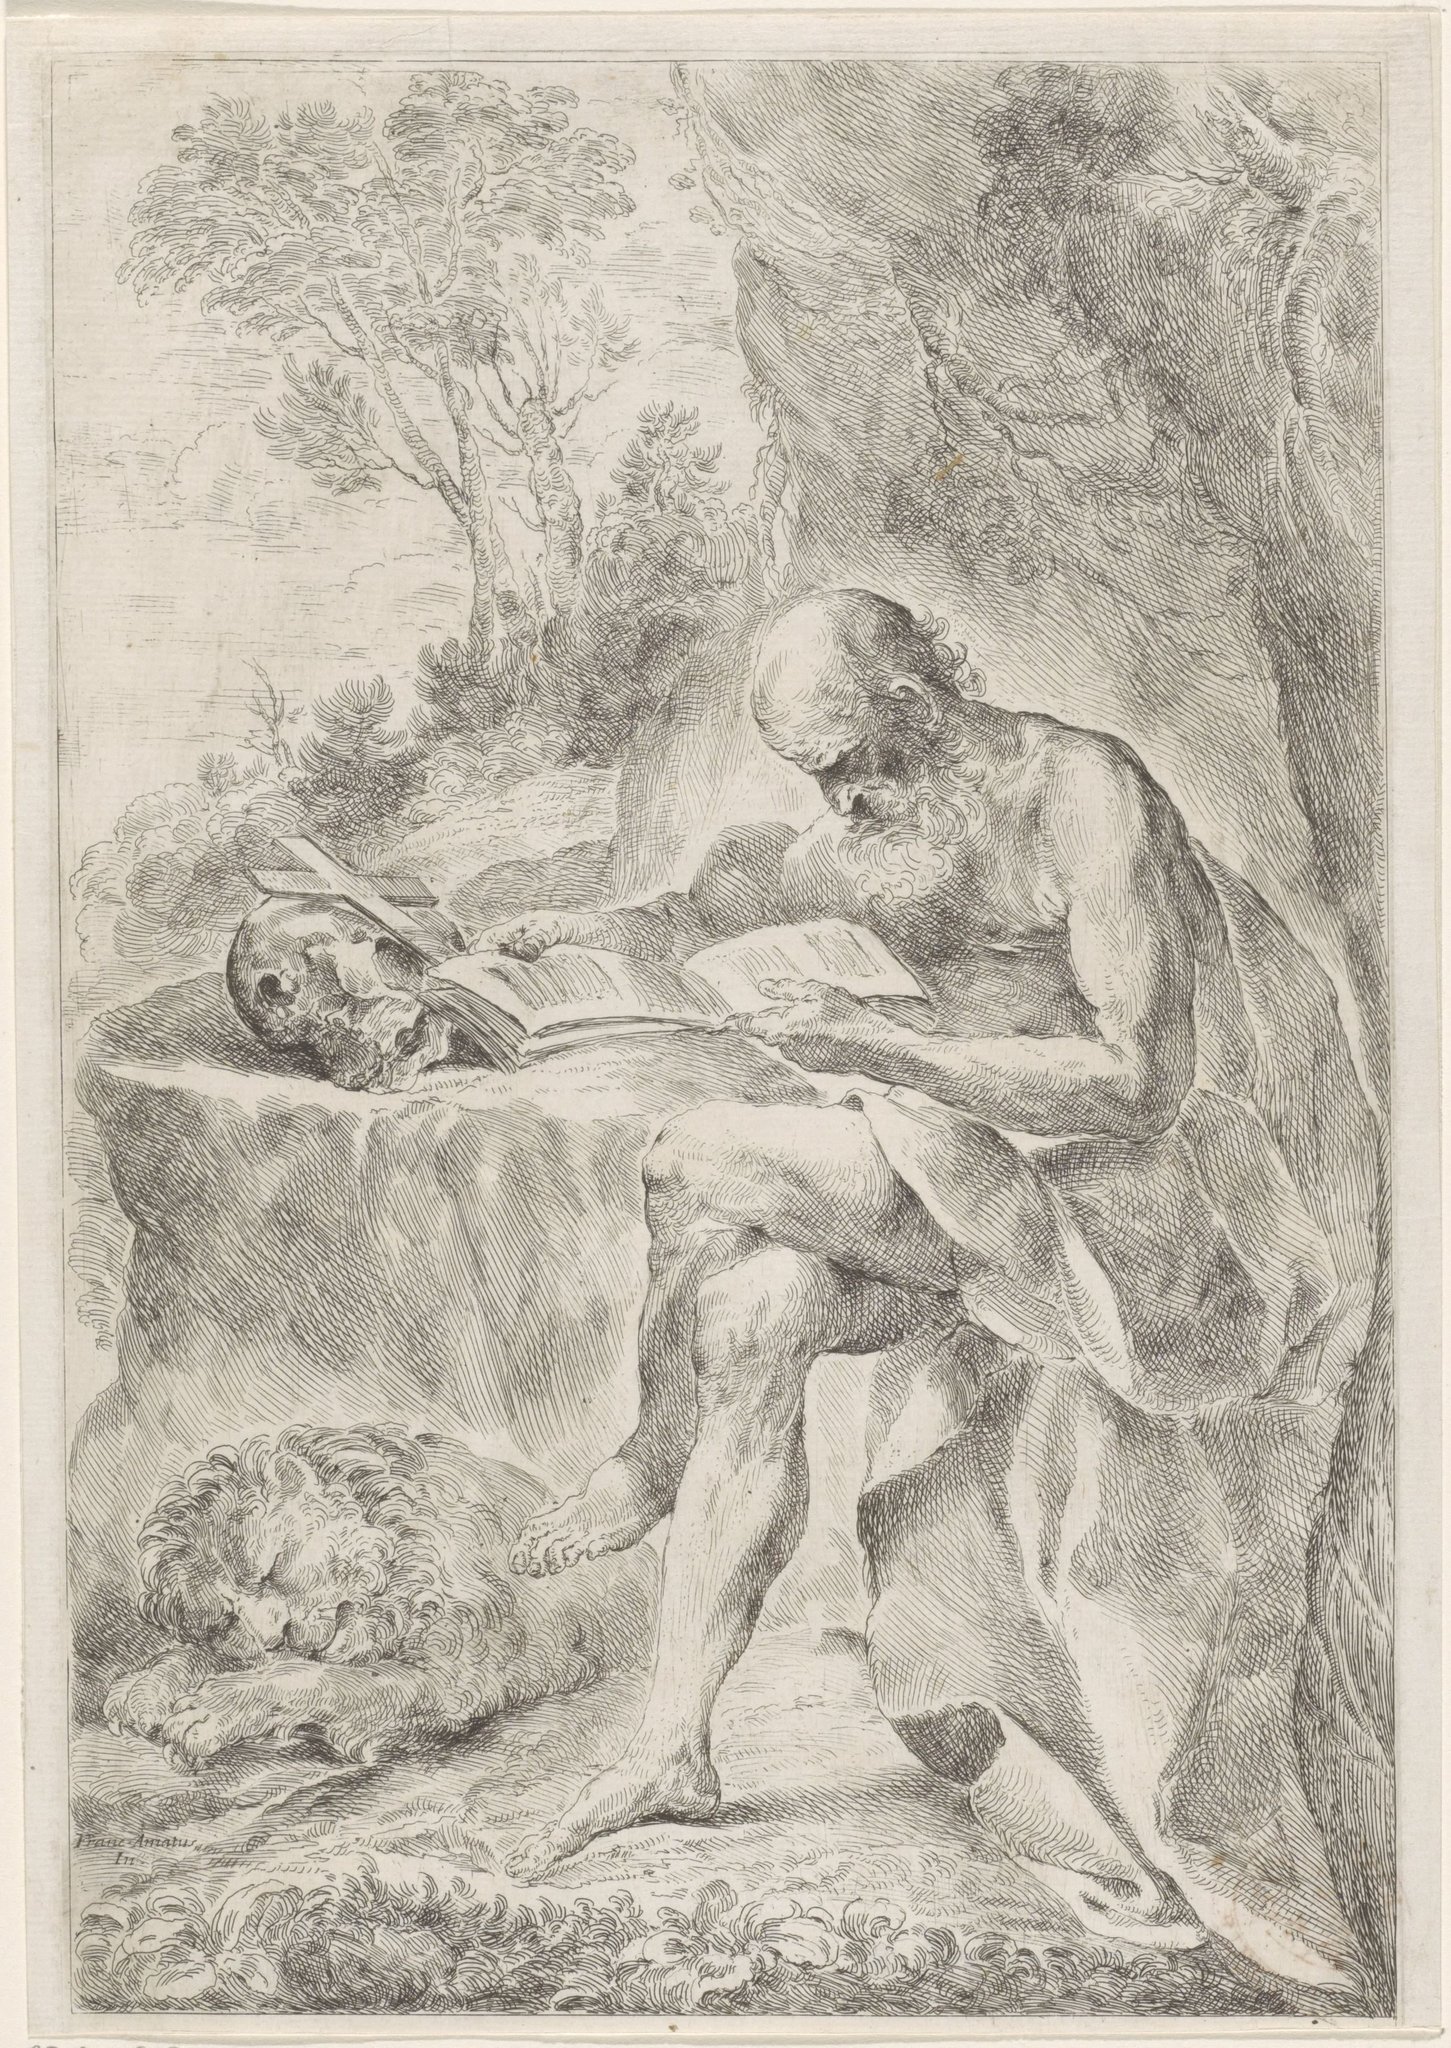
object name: print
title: De heilige Hieronymus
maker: francesco amato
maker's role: painter, print maker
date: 1585-1620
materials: paper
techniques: etching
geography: italy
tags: st. jerome as hermit in a landscape, reading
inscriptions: collector's mark: Lugt 240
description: De heilige Hieronymus zit te lezen in de wildernis. Bij zijn voeten ligt een leeuw, naast hem op een rots liggen een schedel en een kruis.